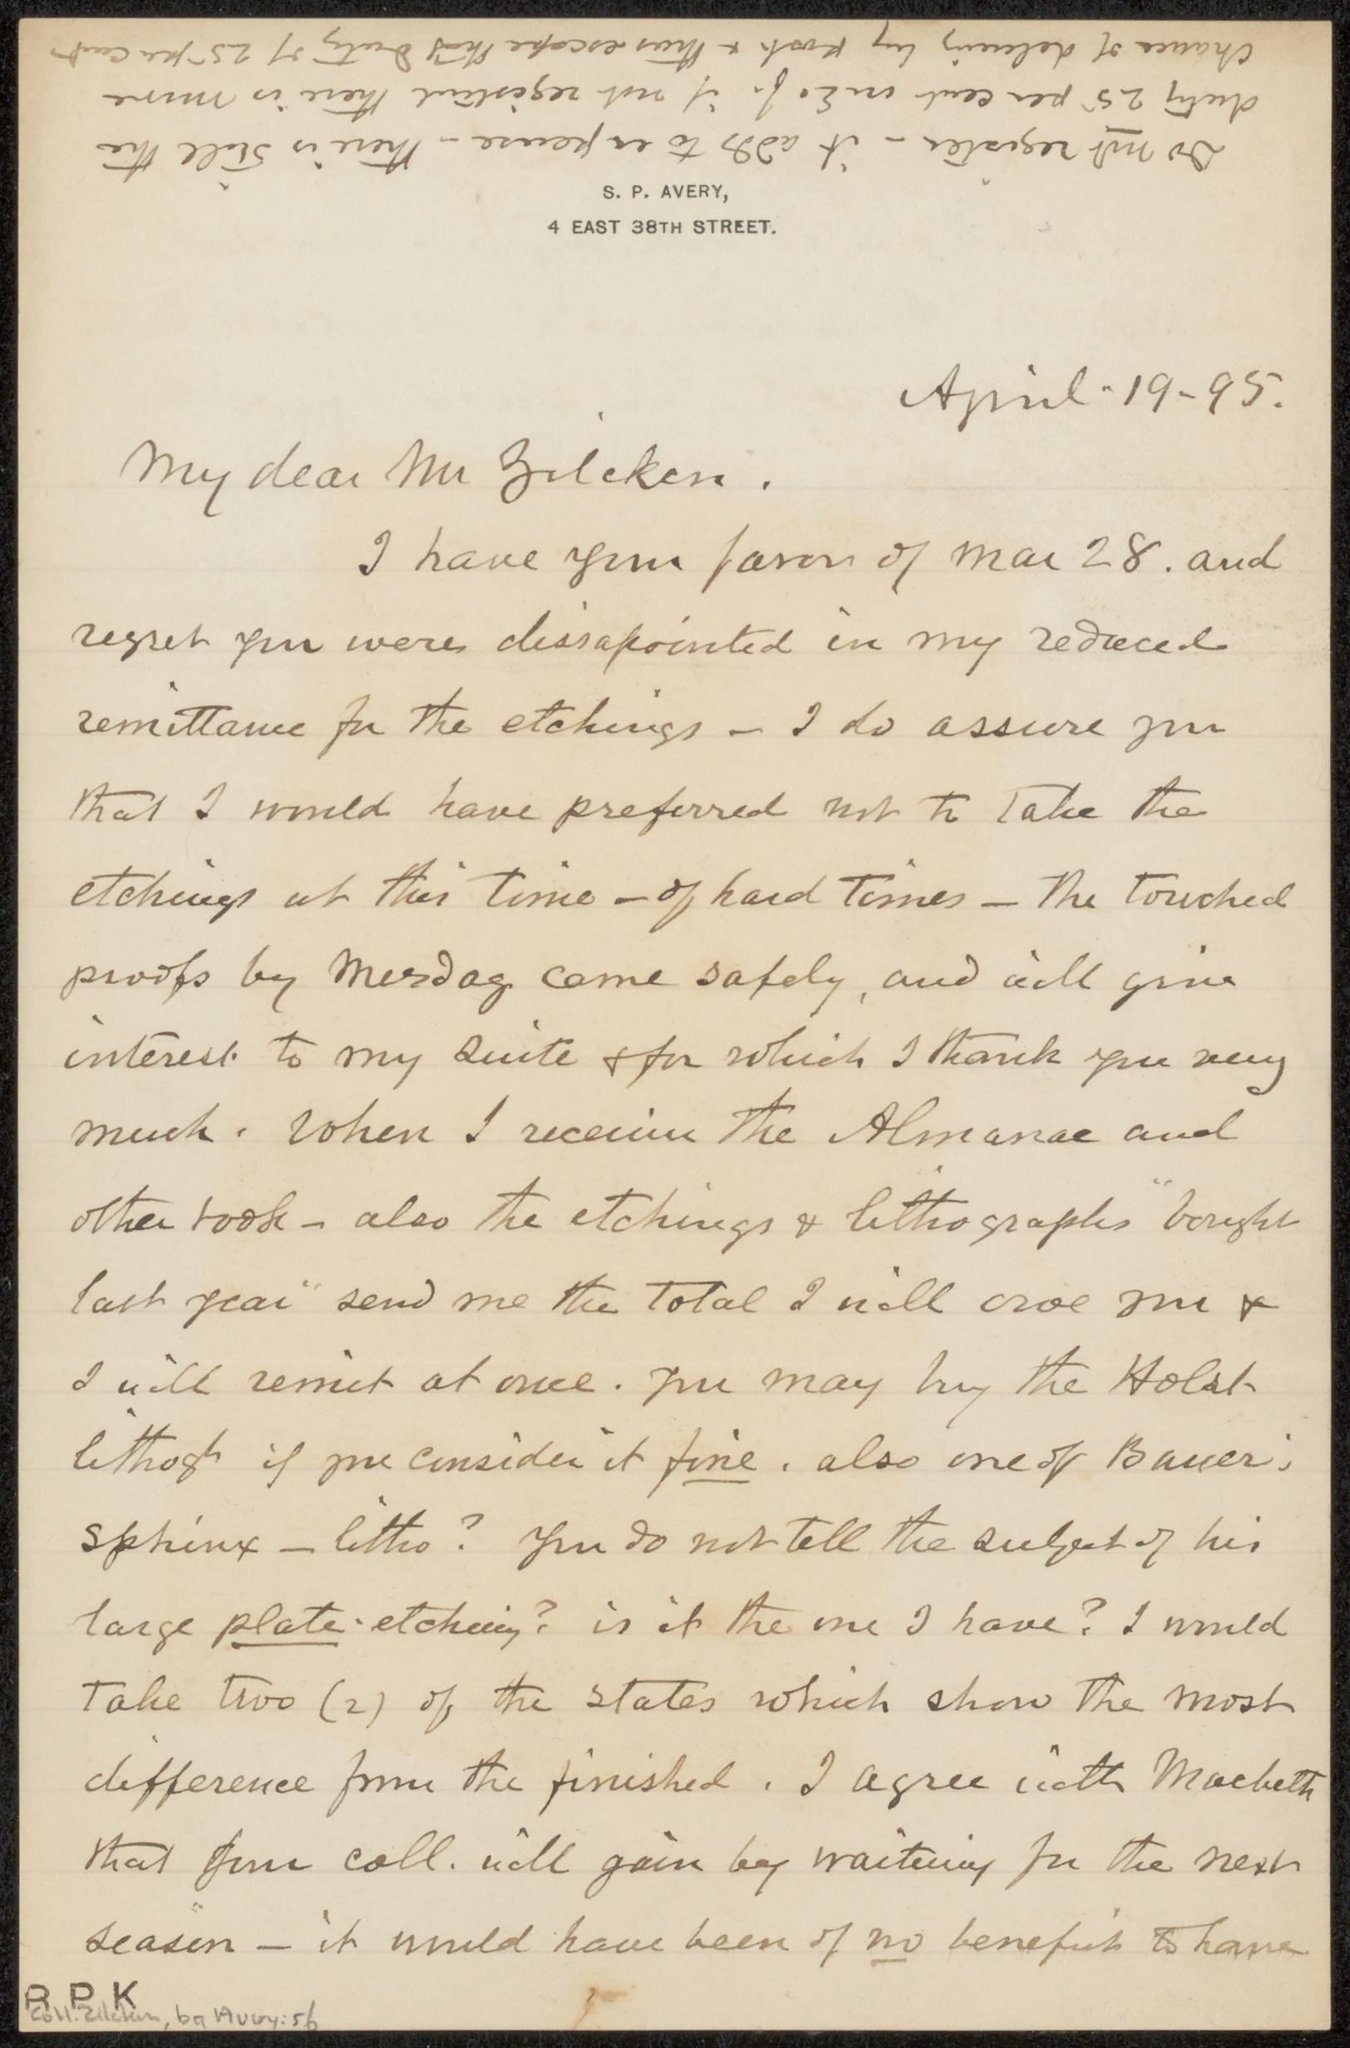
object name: letter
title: Brief aan Philip Zilcken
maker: samuel putnam avery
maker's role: verzamelaar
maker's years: 1822-1904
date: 1895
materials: ink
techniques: pen, printing, writing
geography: new york city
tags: amsterdam, print maker, marius bauer, richard nicolaüs roland holst, the hague, painter, draughtsman, philip zilcken, art trade, art shop, the graphic arts, antwerp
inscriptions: collector's mark: ‘RPK’